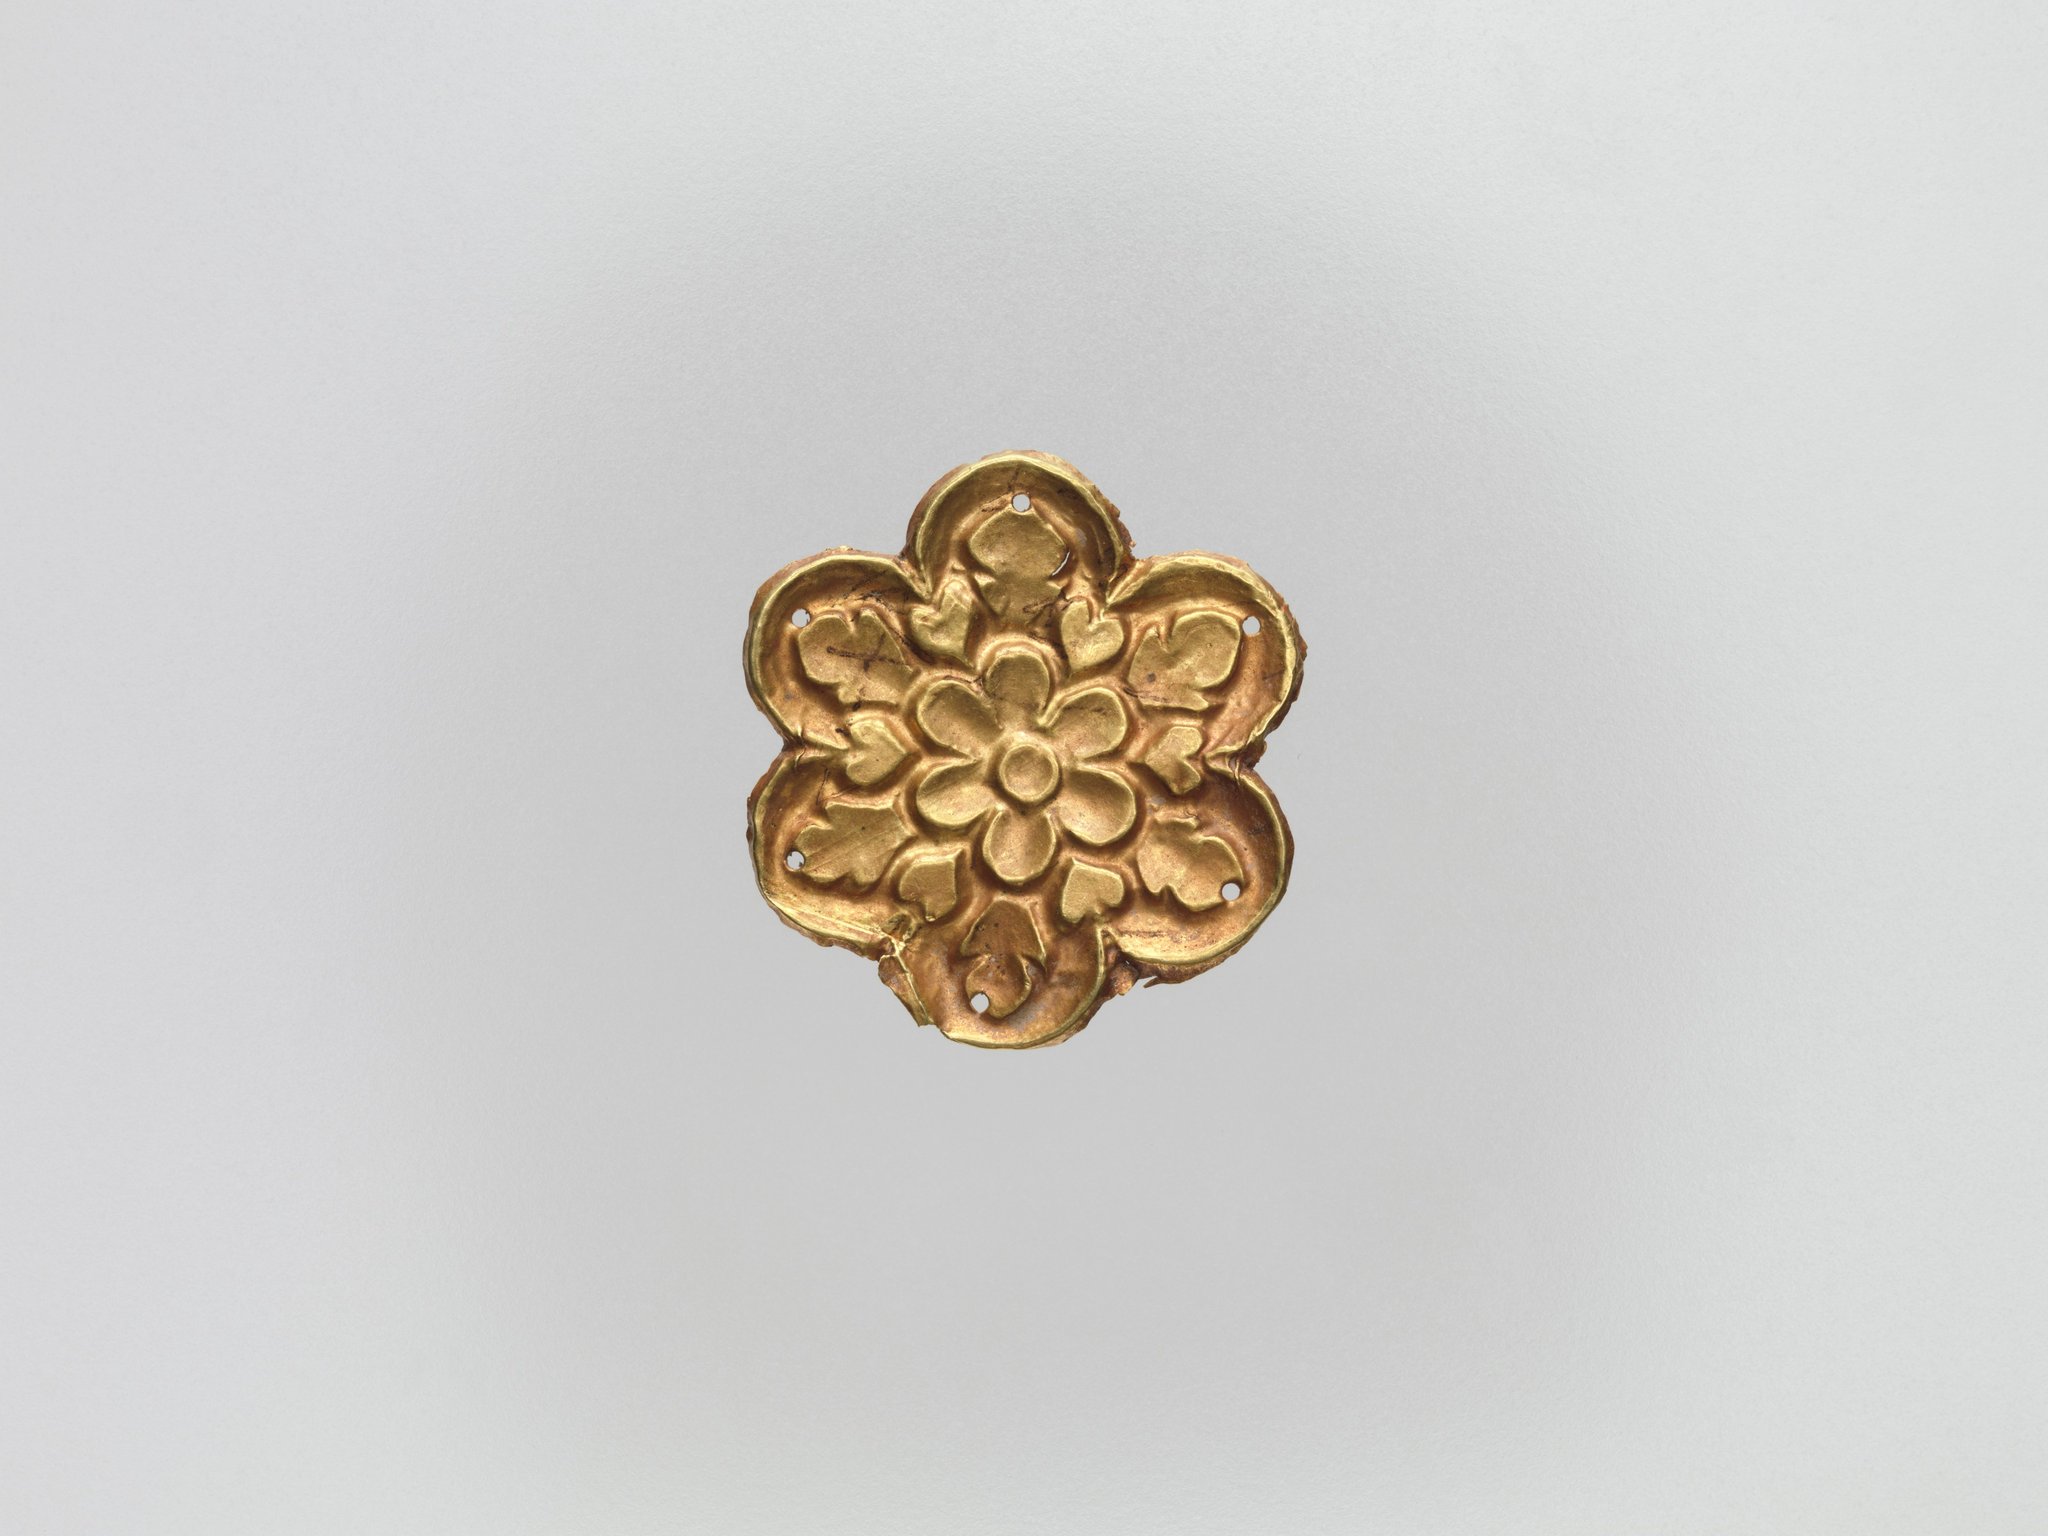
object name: garment plaque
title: Flower-Shaped Clothing Plaque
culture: chinese or central asian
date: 601-900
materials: gold